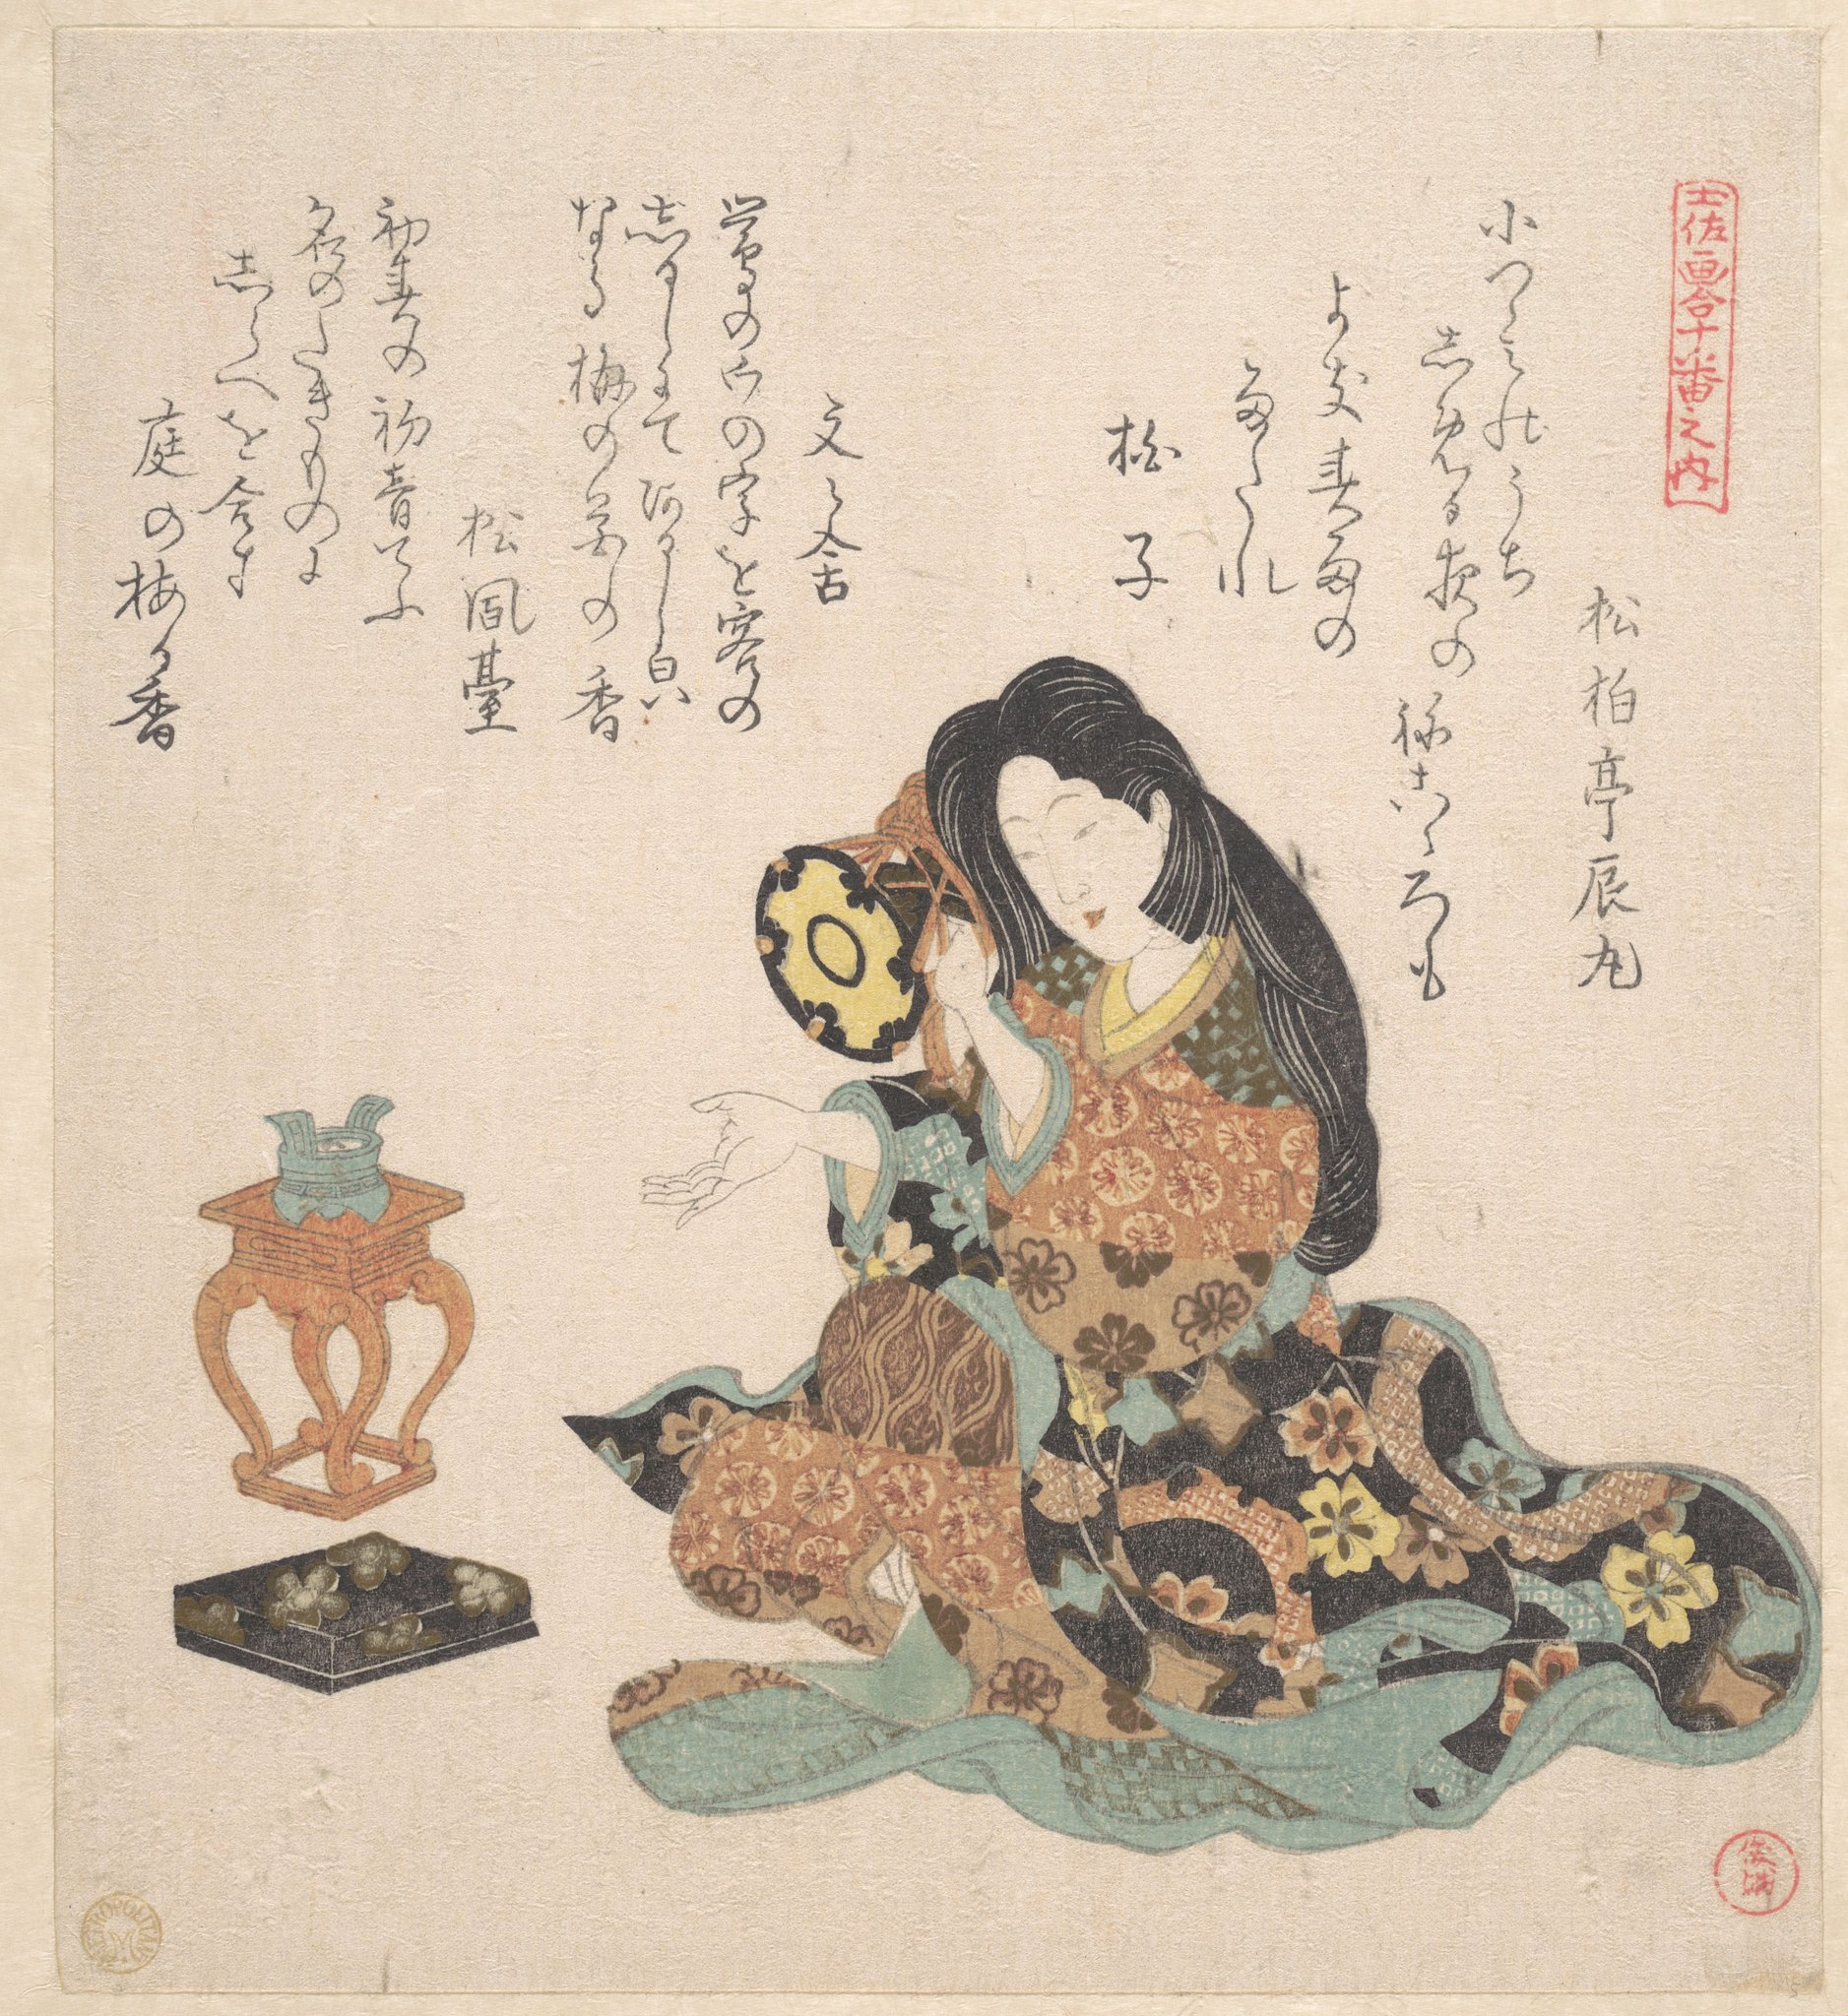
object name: print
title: Woman Playing the Tsuzumi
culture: japanese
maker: kubo shunman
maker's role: artist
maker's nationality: japanese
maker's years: 1757-1820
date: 1800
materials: ink, paper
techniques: surimono, woodblock print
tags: musical instruments,women